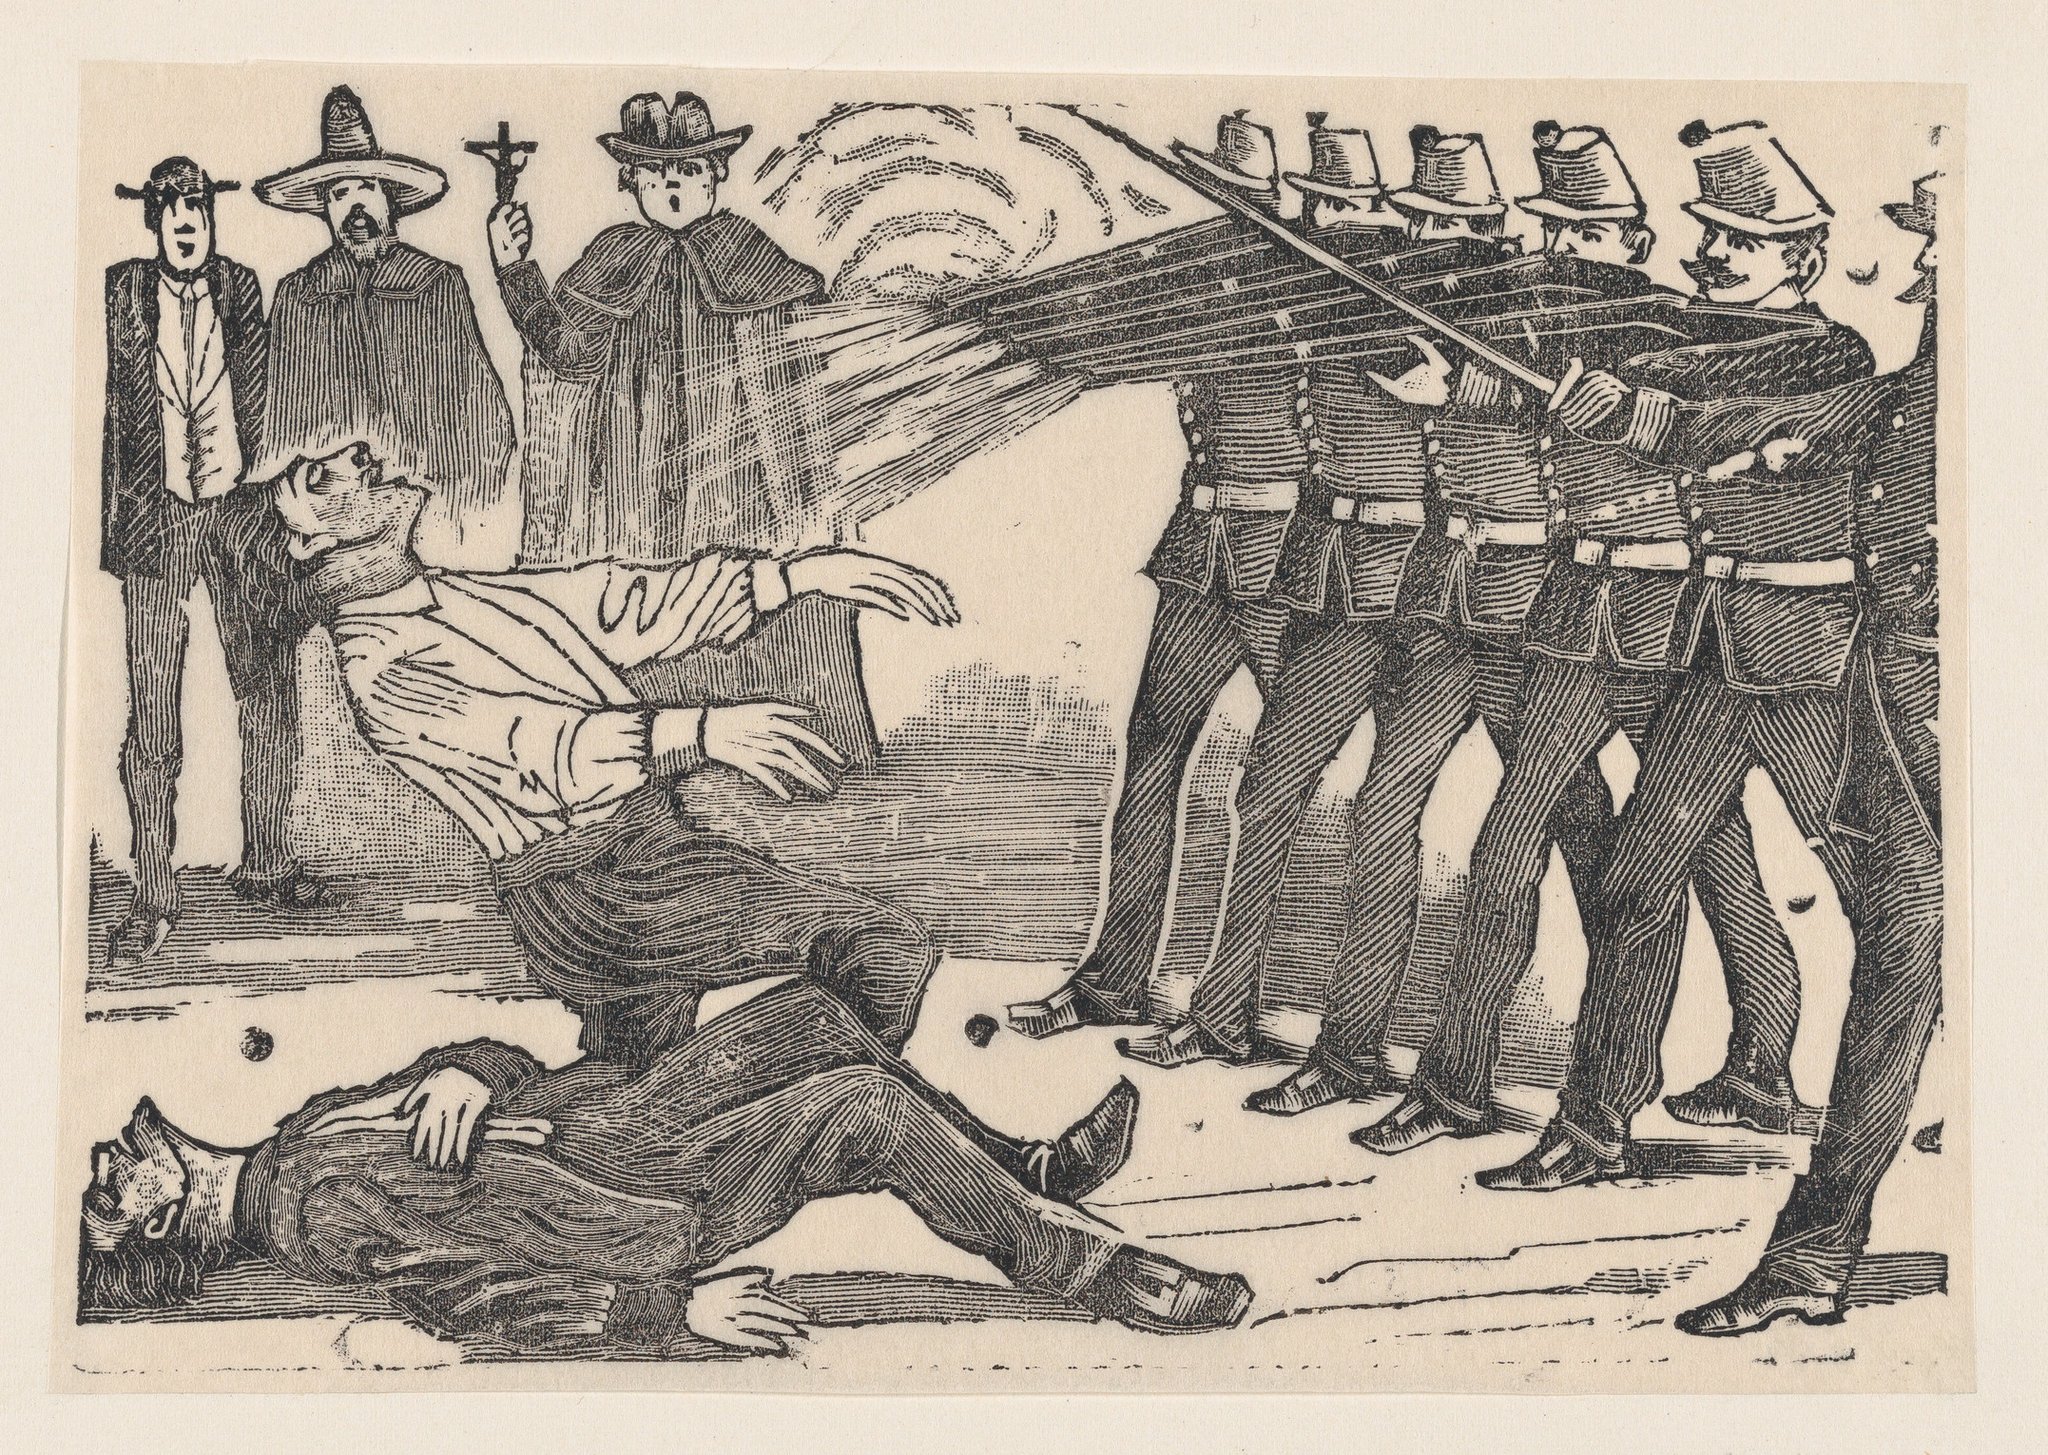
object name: print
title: A firing squad executing two men, a priest and other figures in the background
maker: josé guadalupe posada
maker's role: artist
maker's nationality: mexican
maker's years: 1852-1913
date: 1892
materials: metal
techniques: engraving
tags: military,firearms,men,death,execution